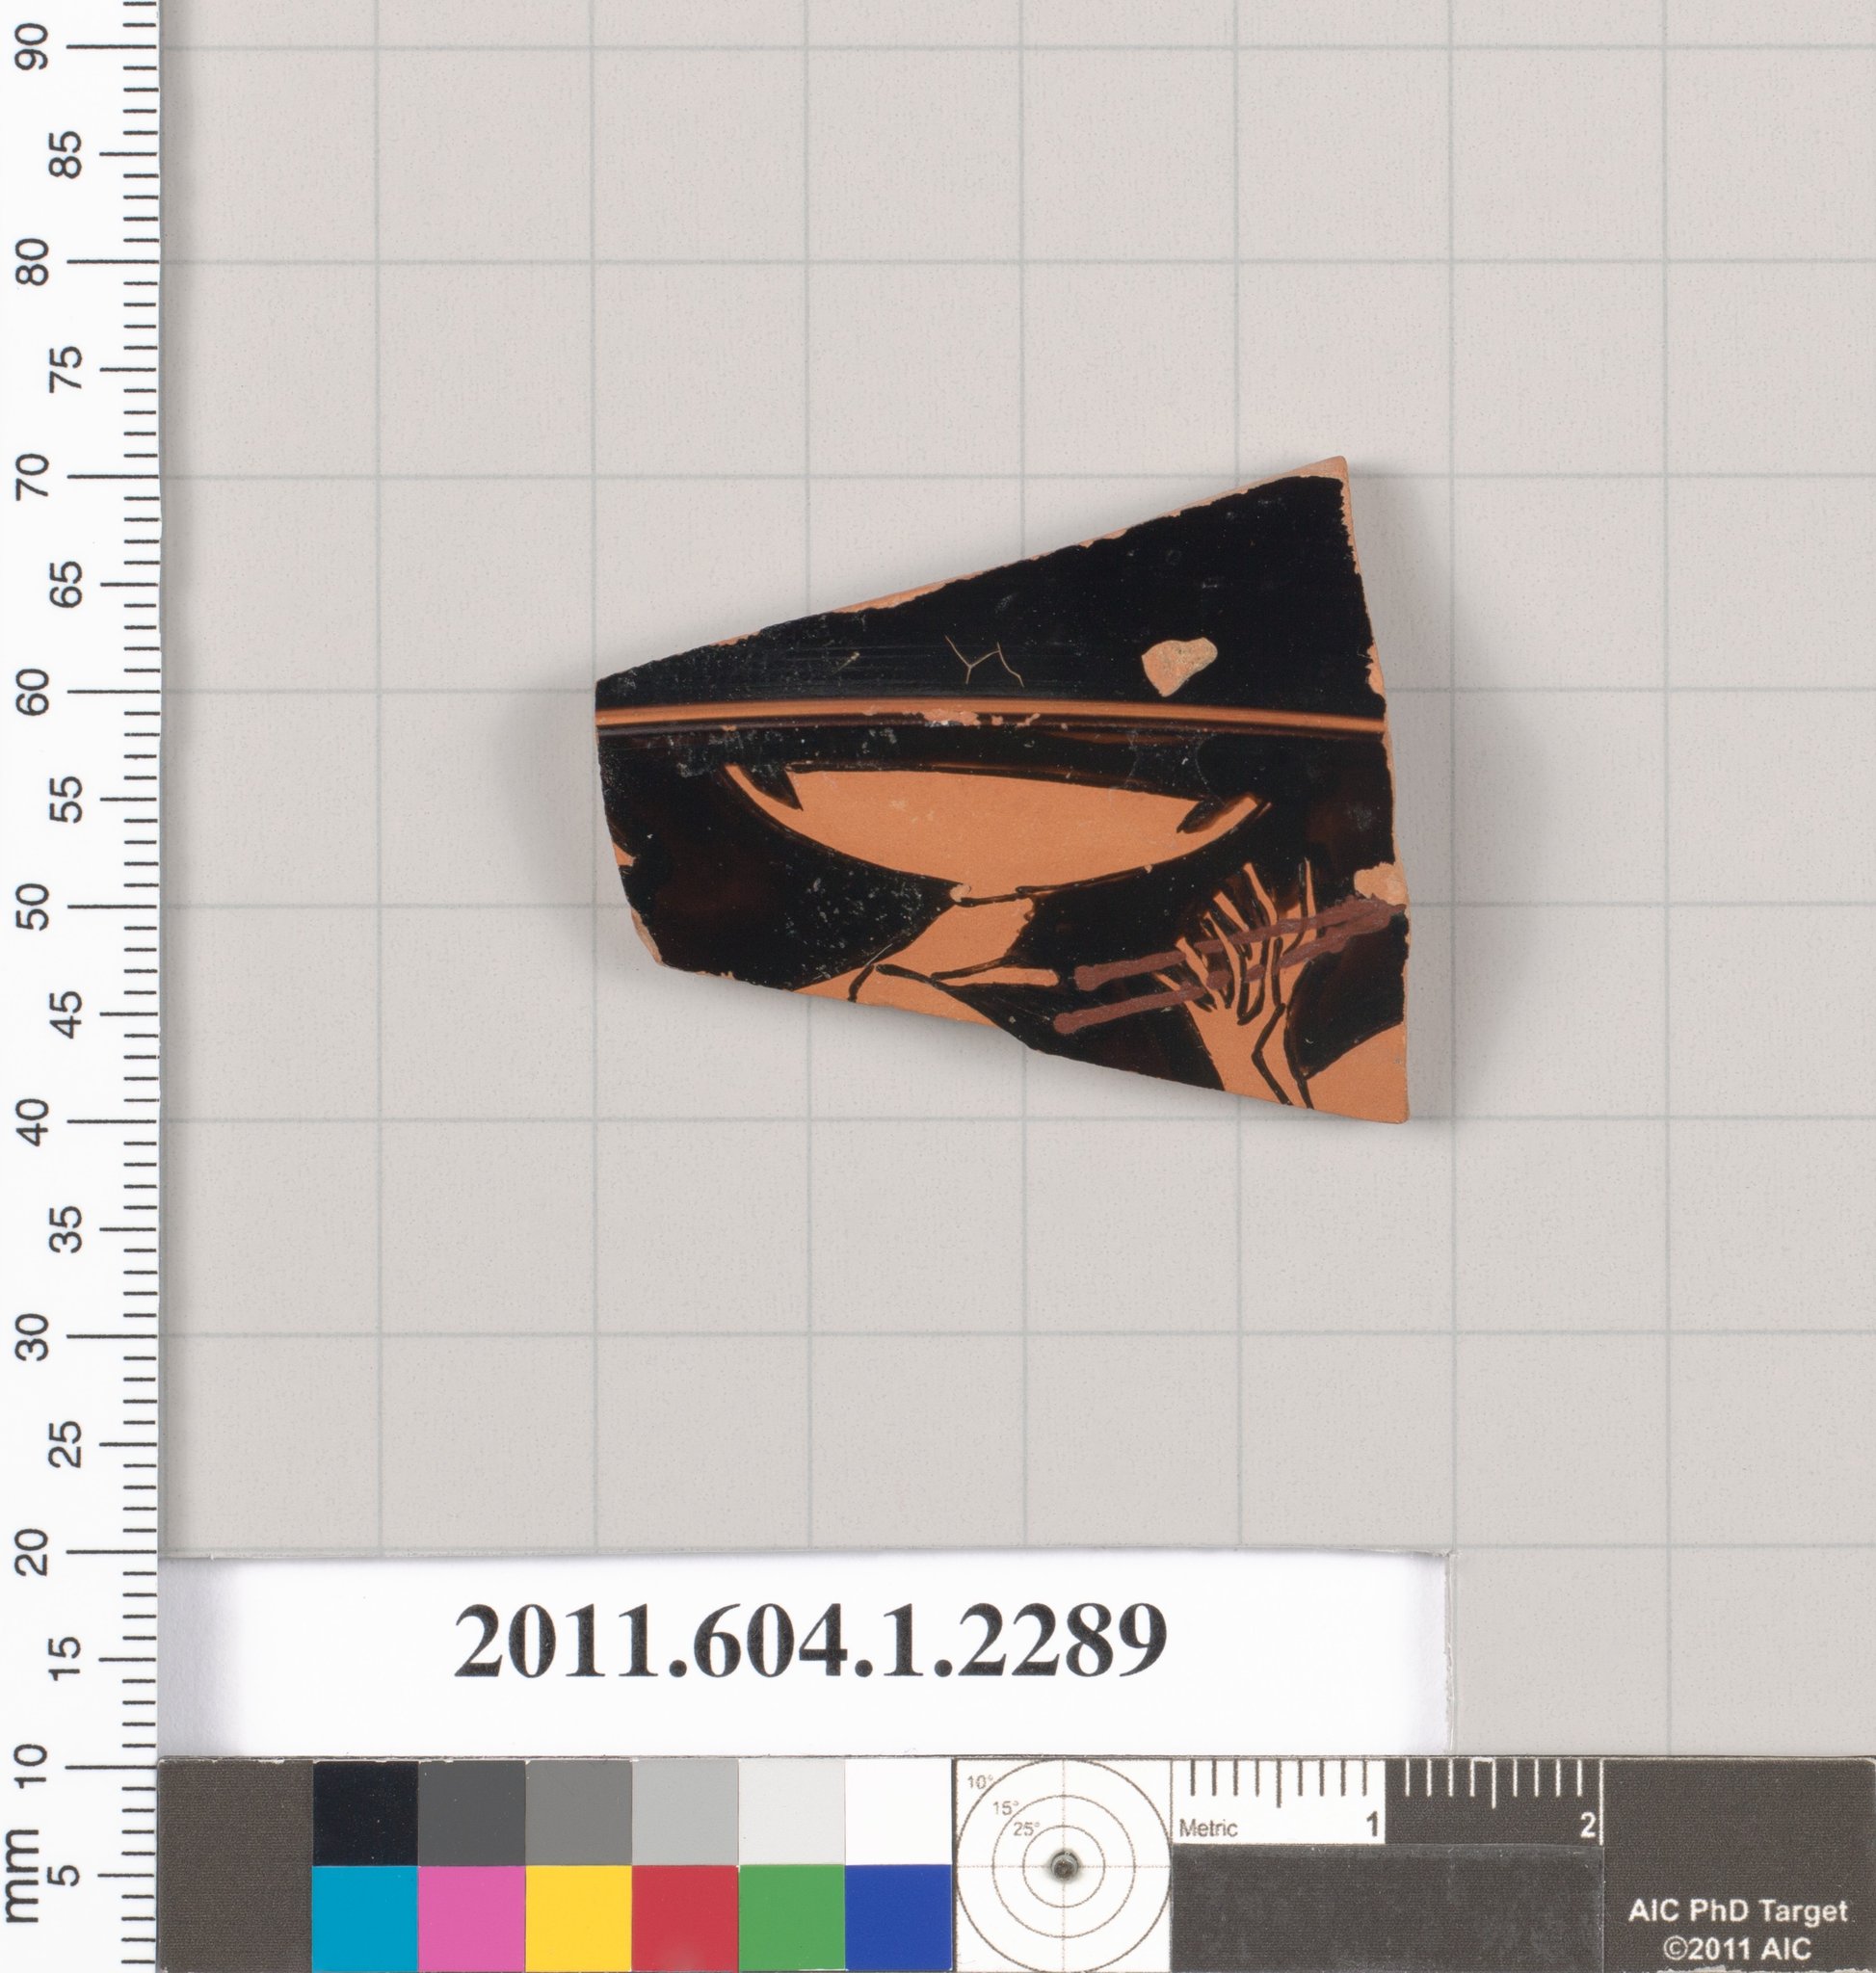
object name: kylix fragment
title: Terracotta fragment of a kylix (drinking cup)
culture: greek, attic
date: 490-480 BCE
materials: terracotta